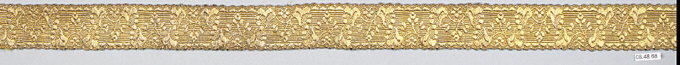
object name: galloon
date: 1600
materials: metal thread